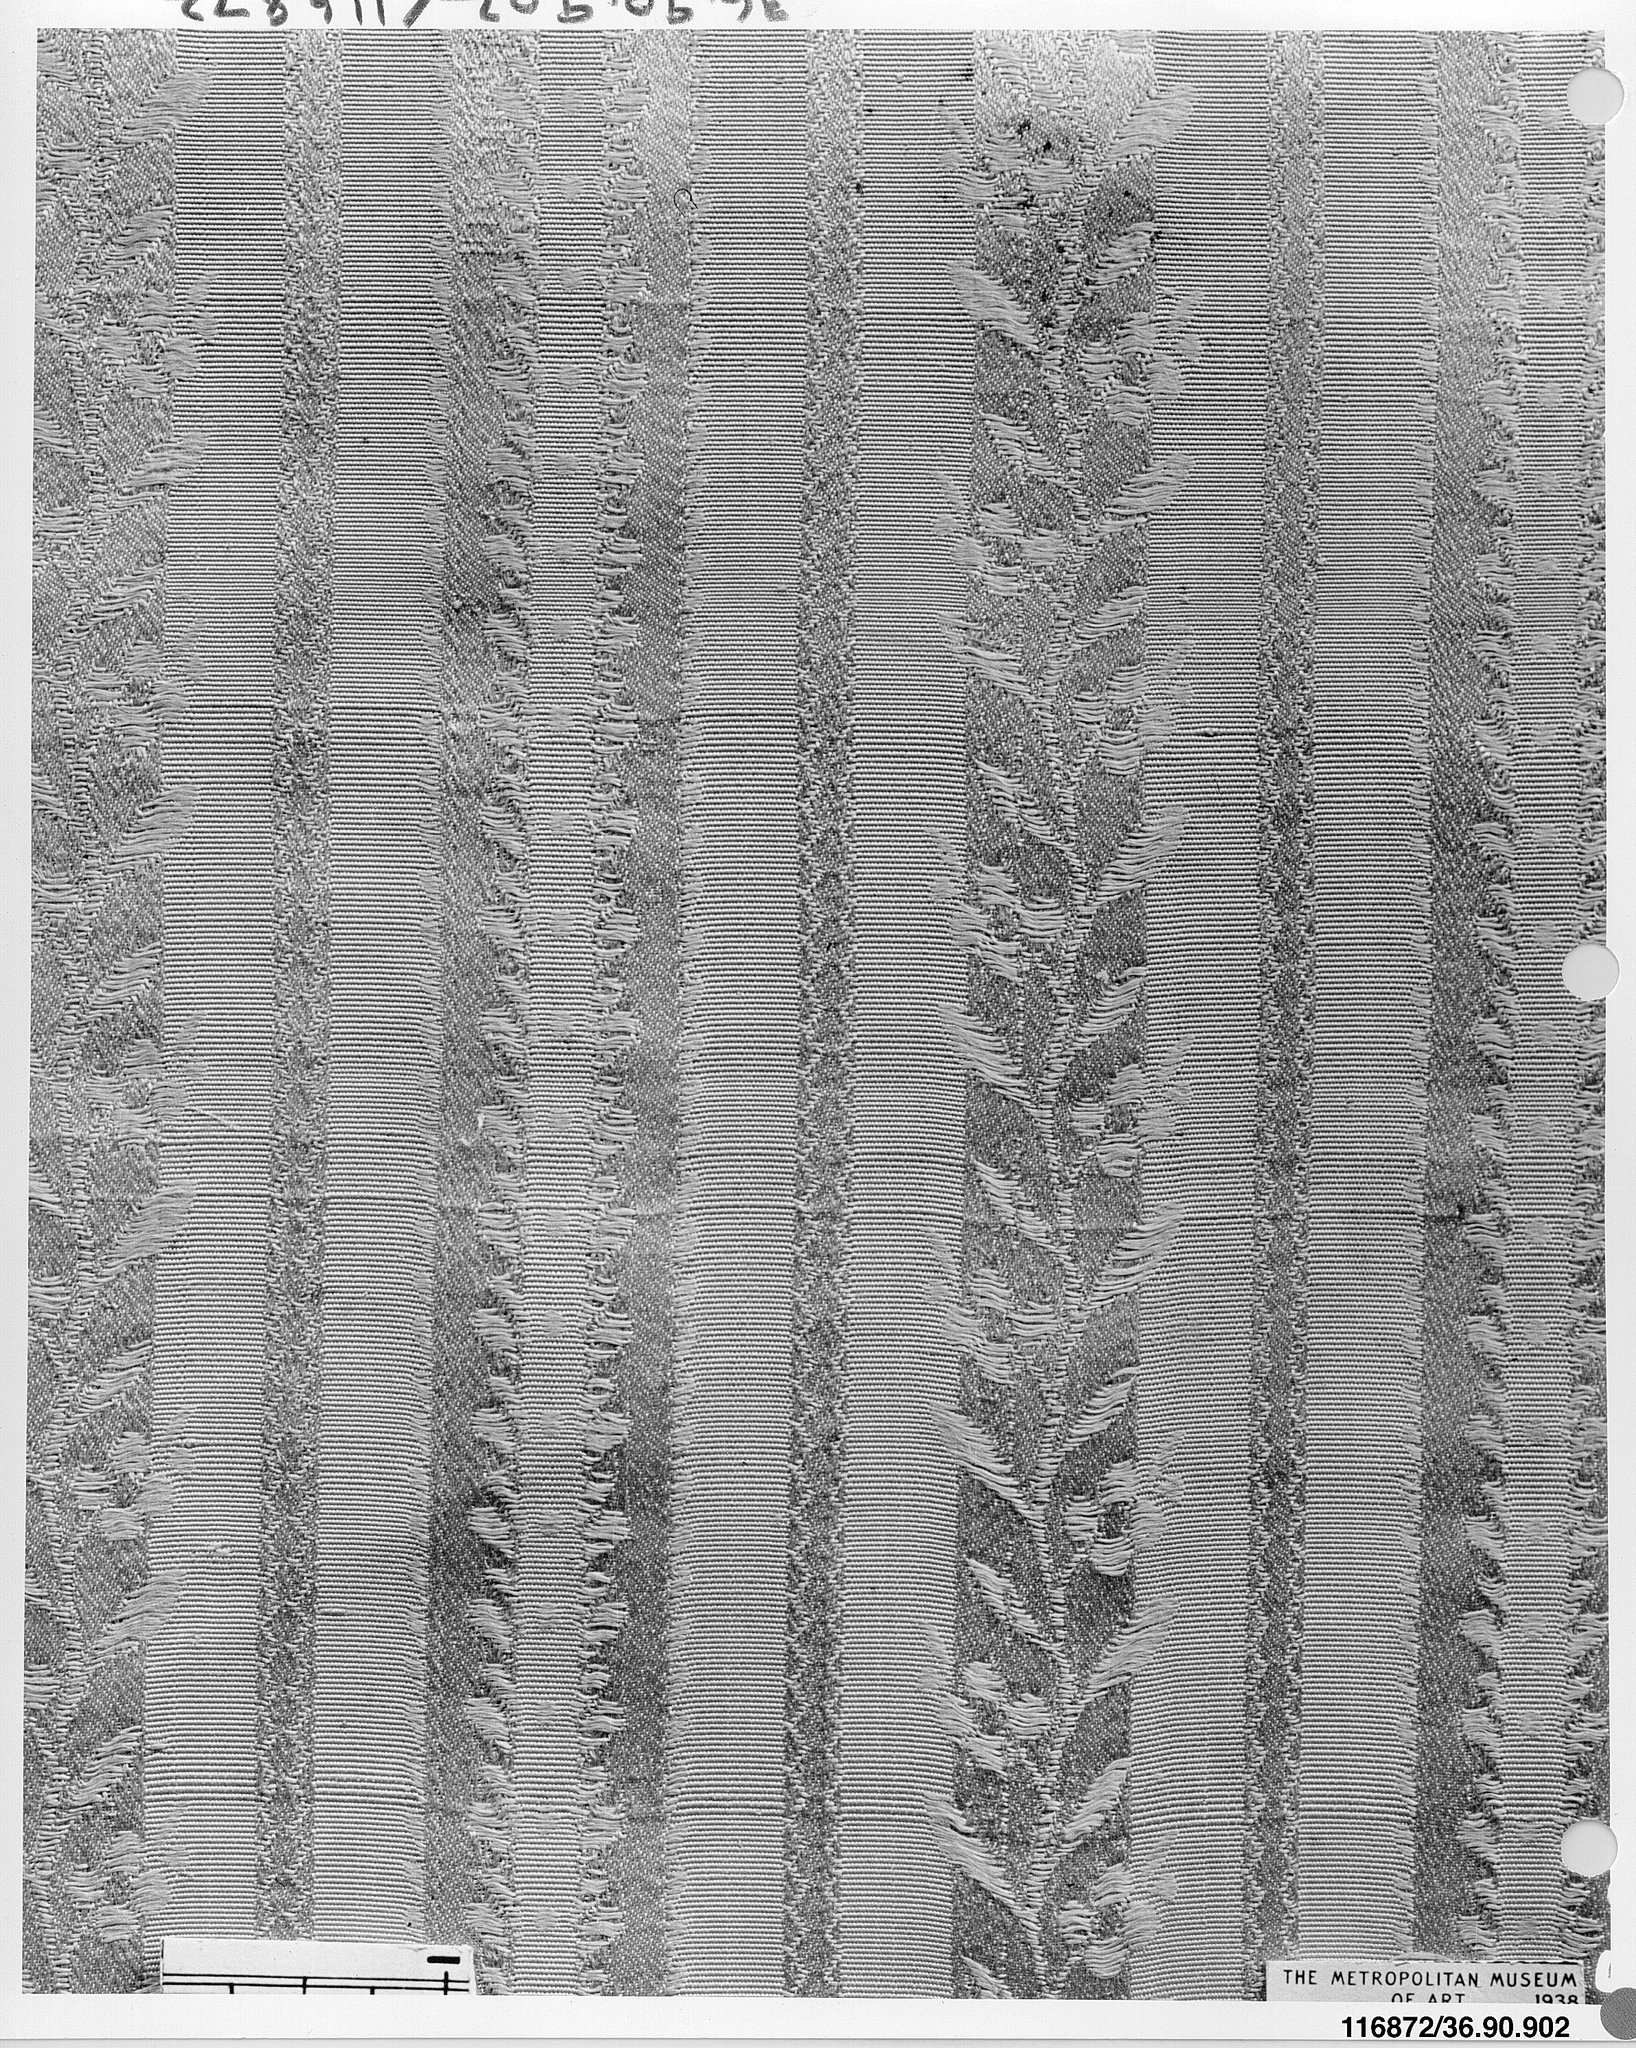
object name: piece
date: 1701-1800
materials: silk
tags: flowers,leaves